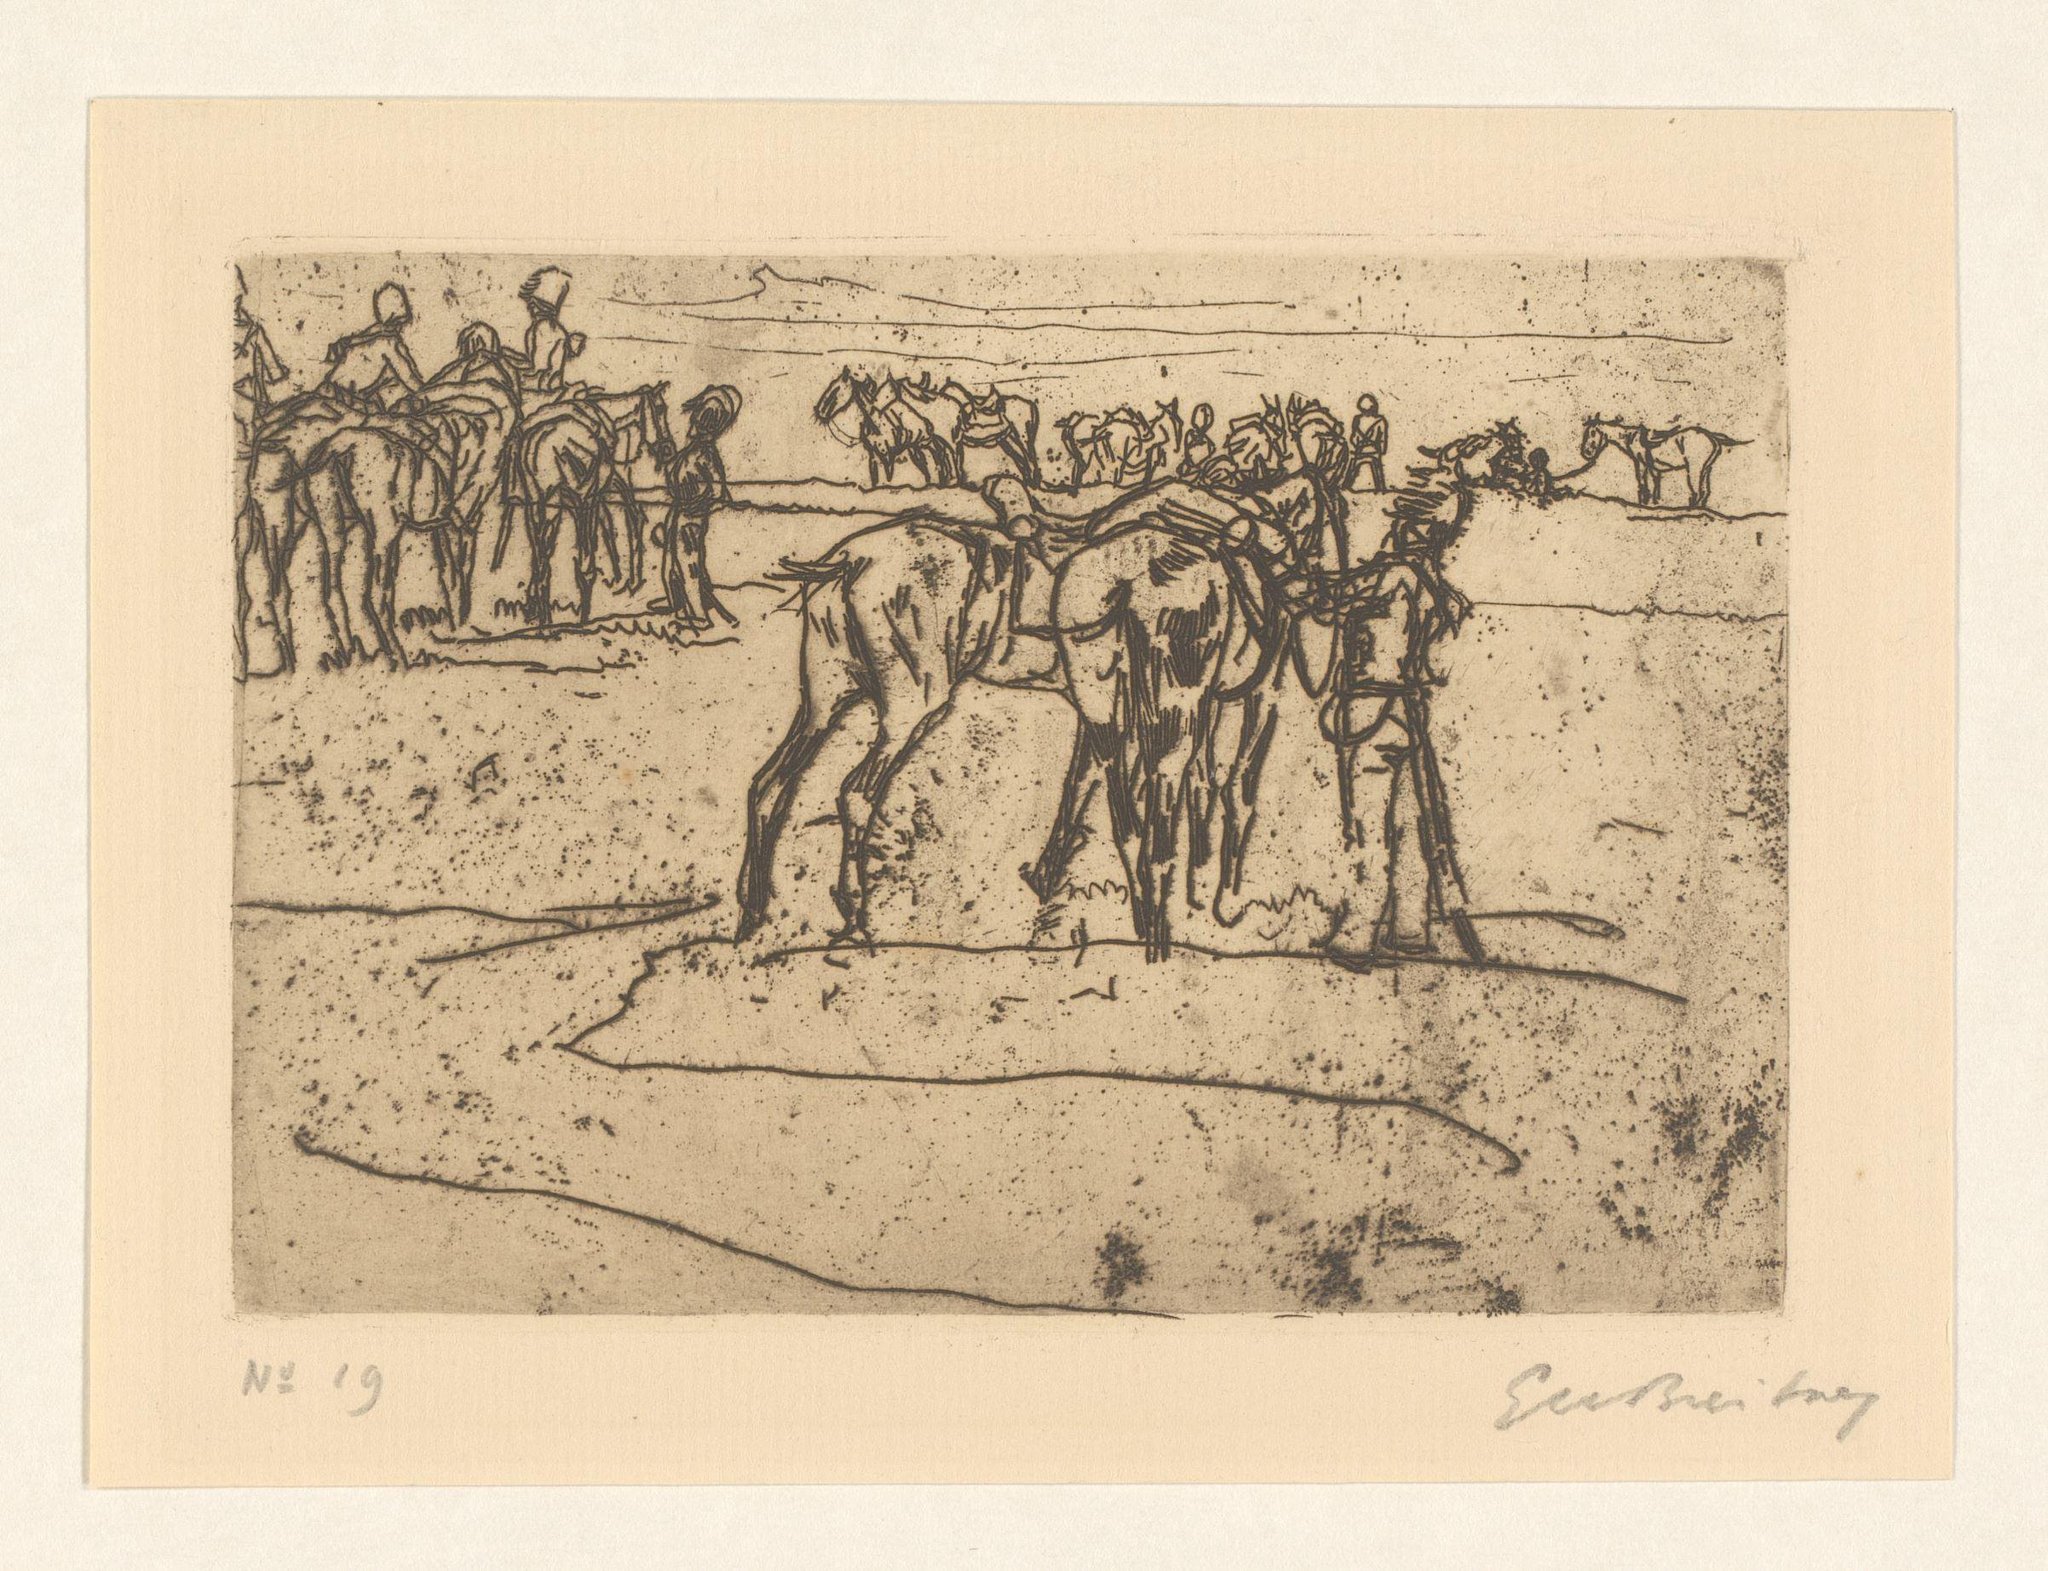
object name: print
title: Rustende cavalerie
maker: george hendrik breitner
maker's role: draughtsman, painter, print maker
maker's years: 1857-1923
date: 1891-1893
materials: paper, ink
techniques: etching, intaglio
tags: the soldier off duty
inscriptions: number: ‘No 19’, signature: ‘GH Breitner’, collector's mark: Lugt 2228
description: Rustende cavalerie met op de voorgrond een soldaat staand bij twee paarden.